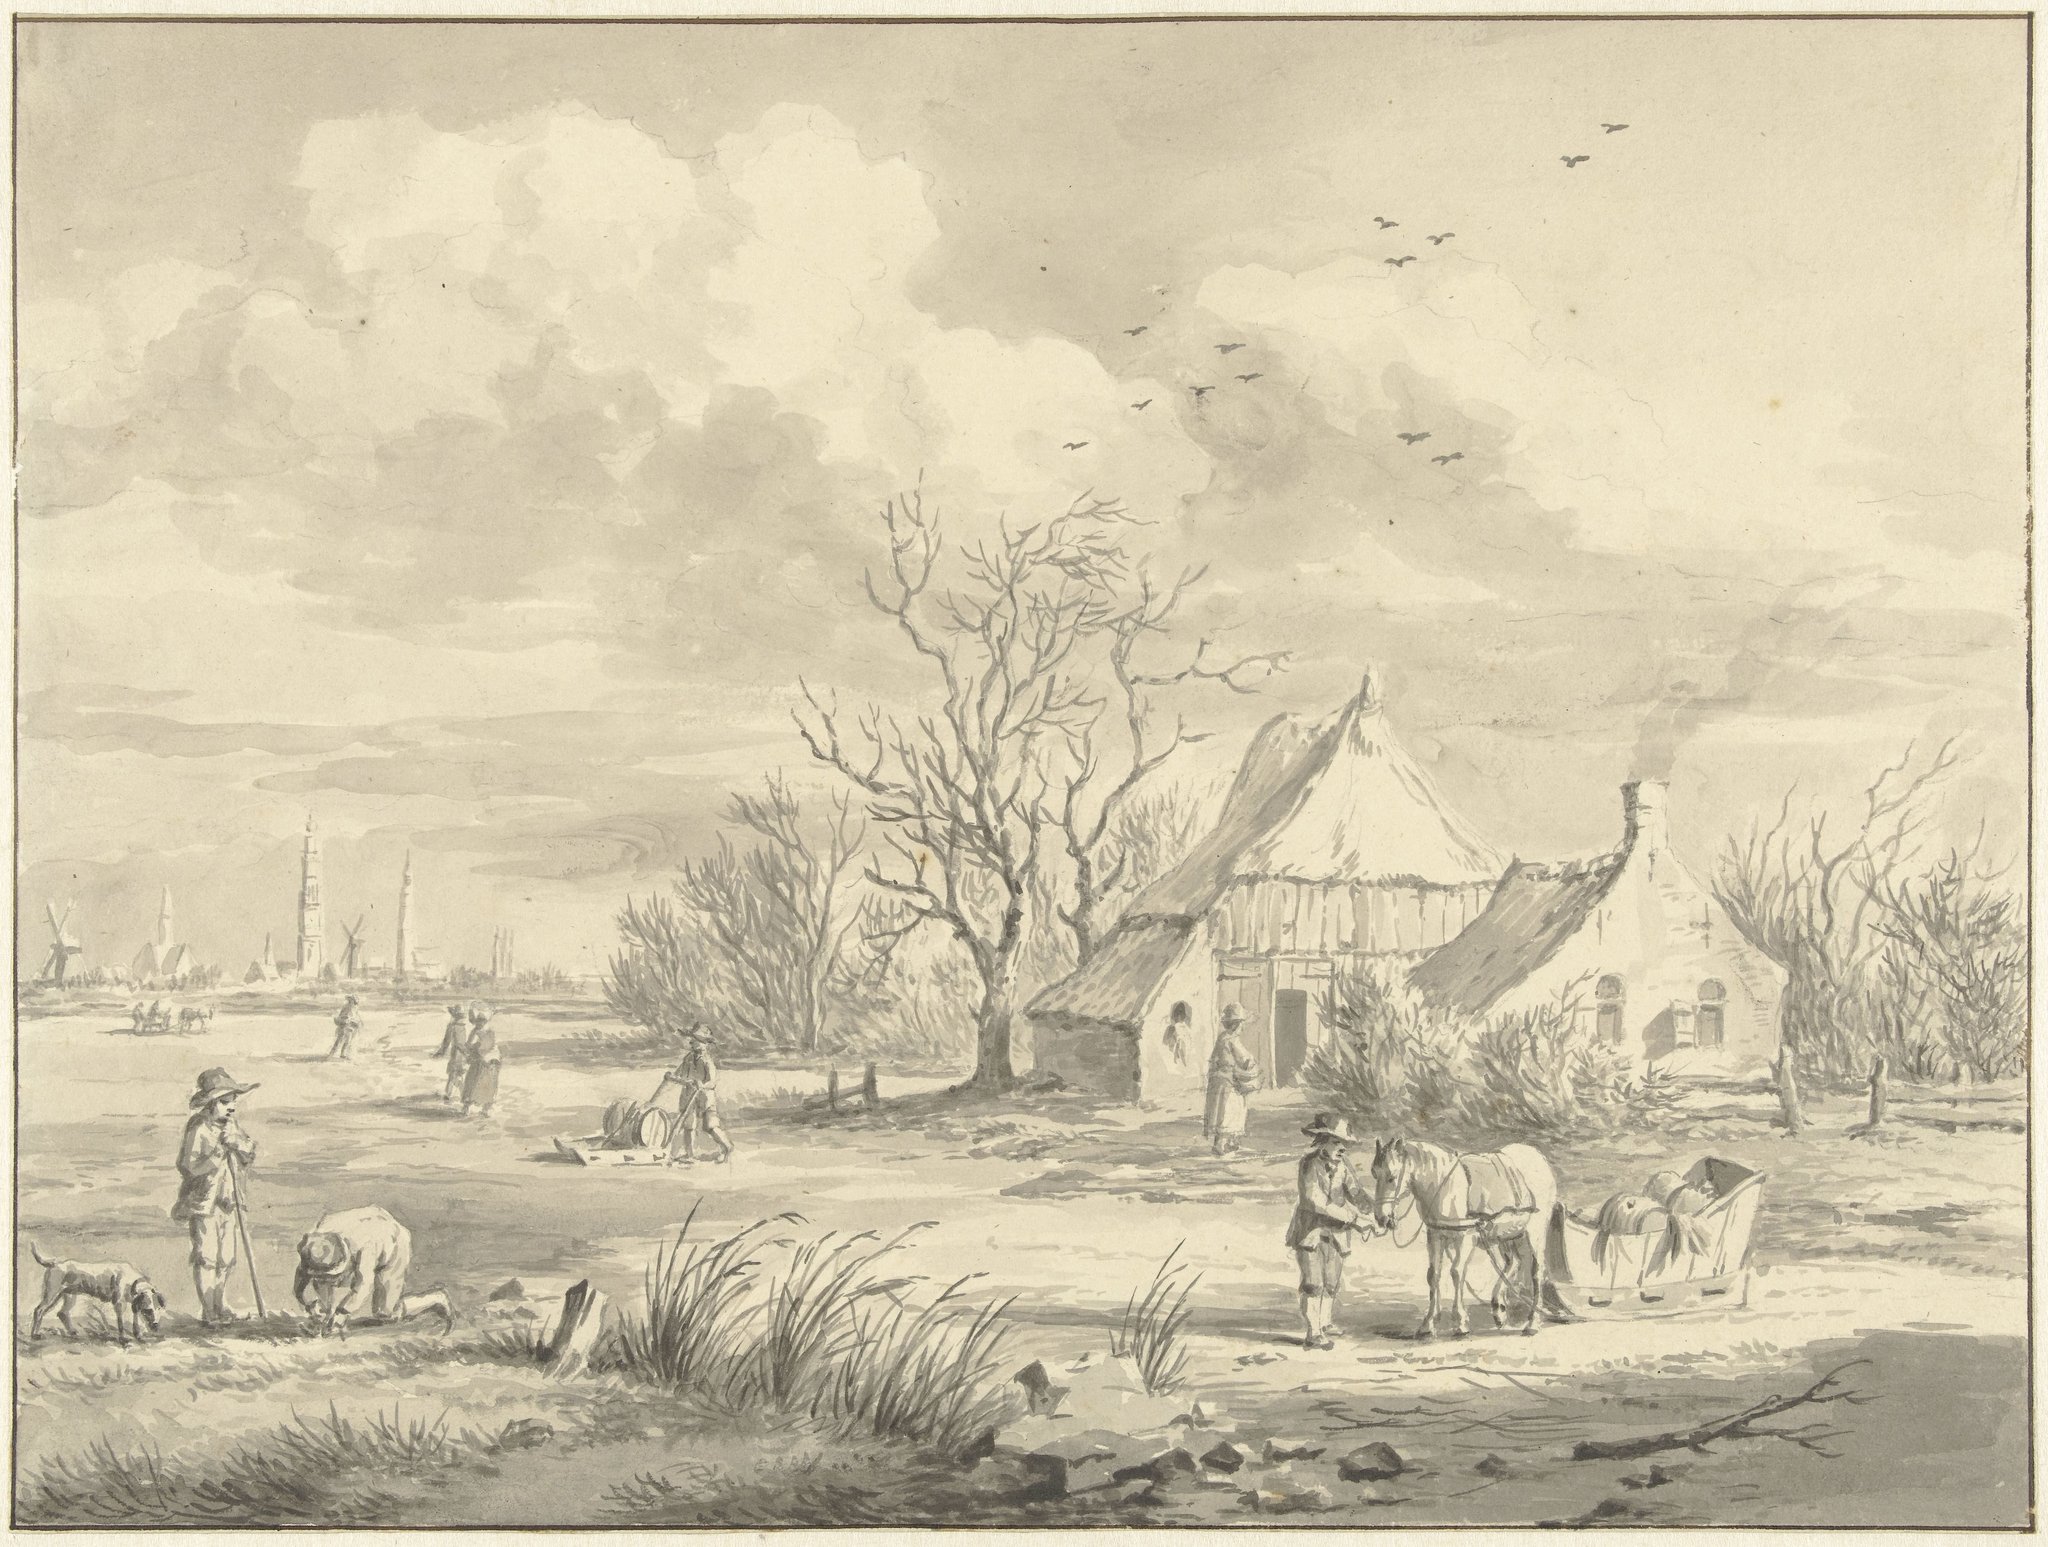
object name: drawing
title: Het Porenhuis met in de verte de stad Groningen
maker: egbert van marum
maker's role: draughtsman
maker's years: 1746-1816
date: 1756-1816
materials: ink, paper, pencil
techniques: brush, pen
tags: prospect of city, town panorama, silhouette of city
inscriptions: inscription: ‘porenhuis’